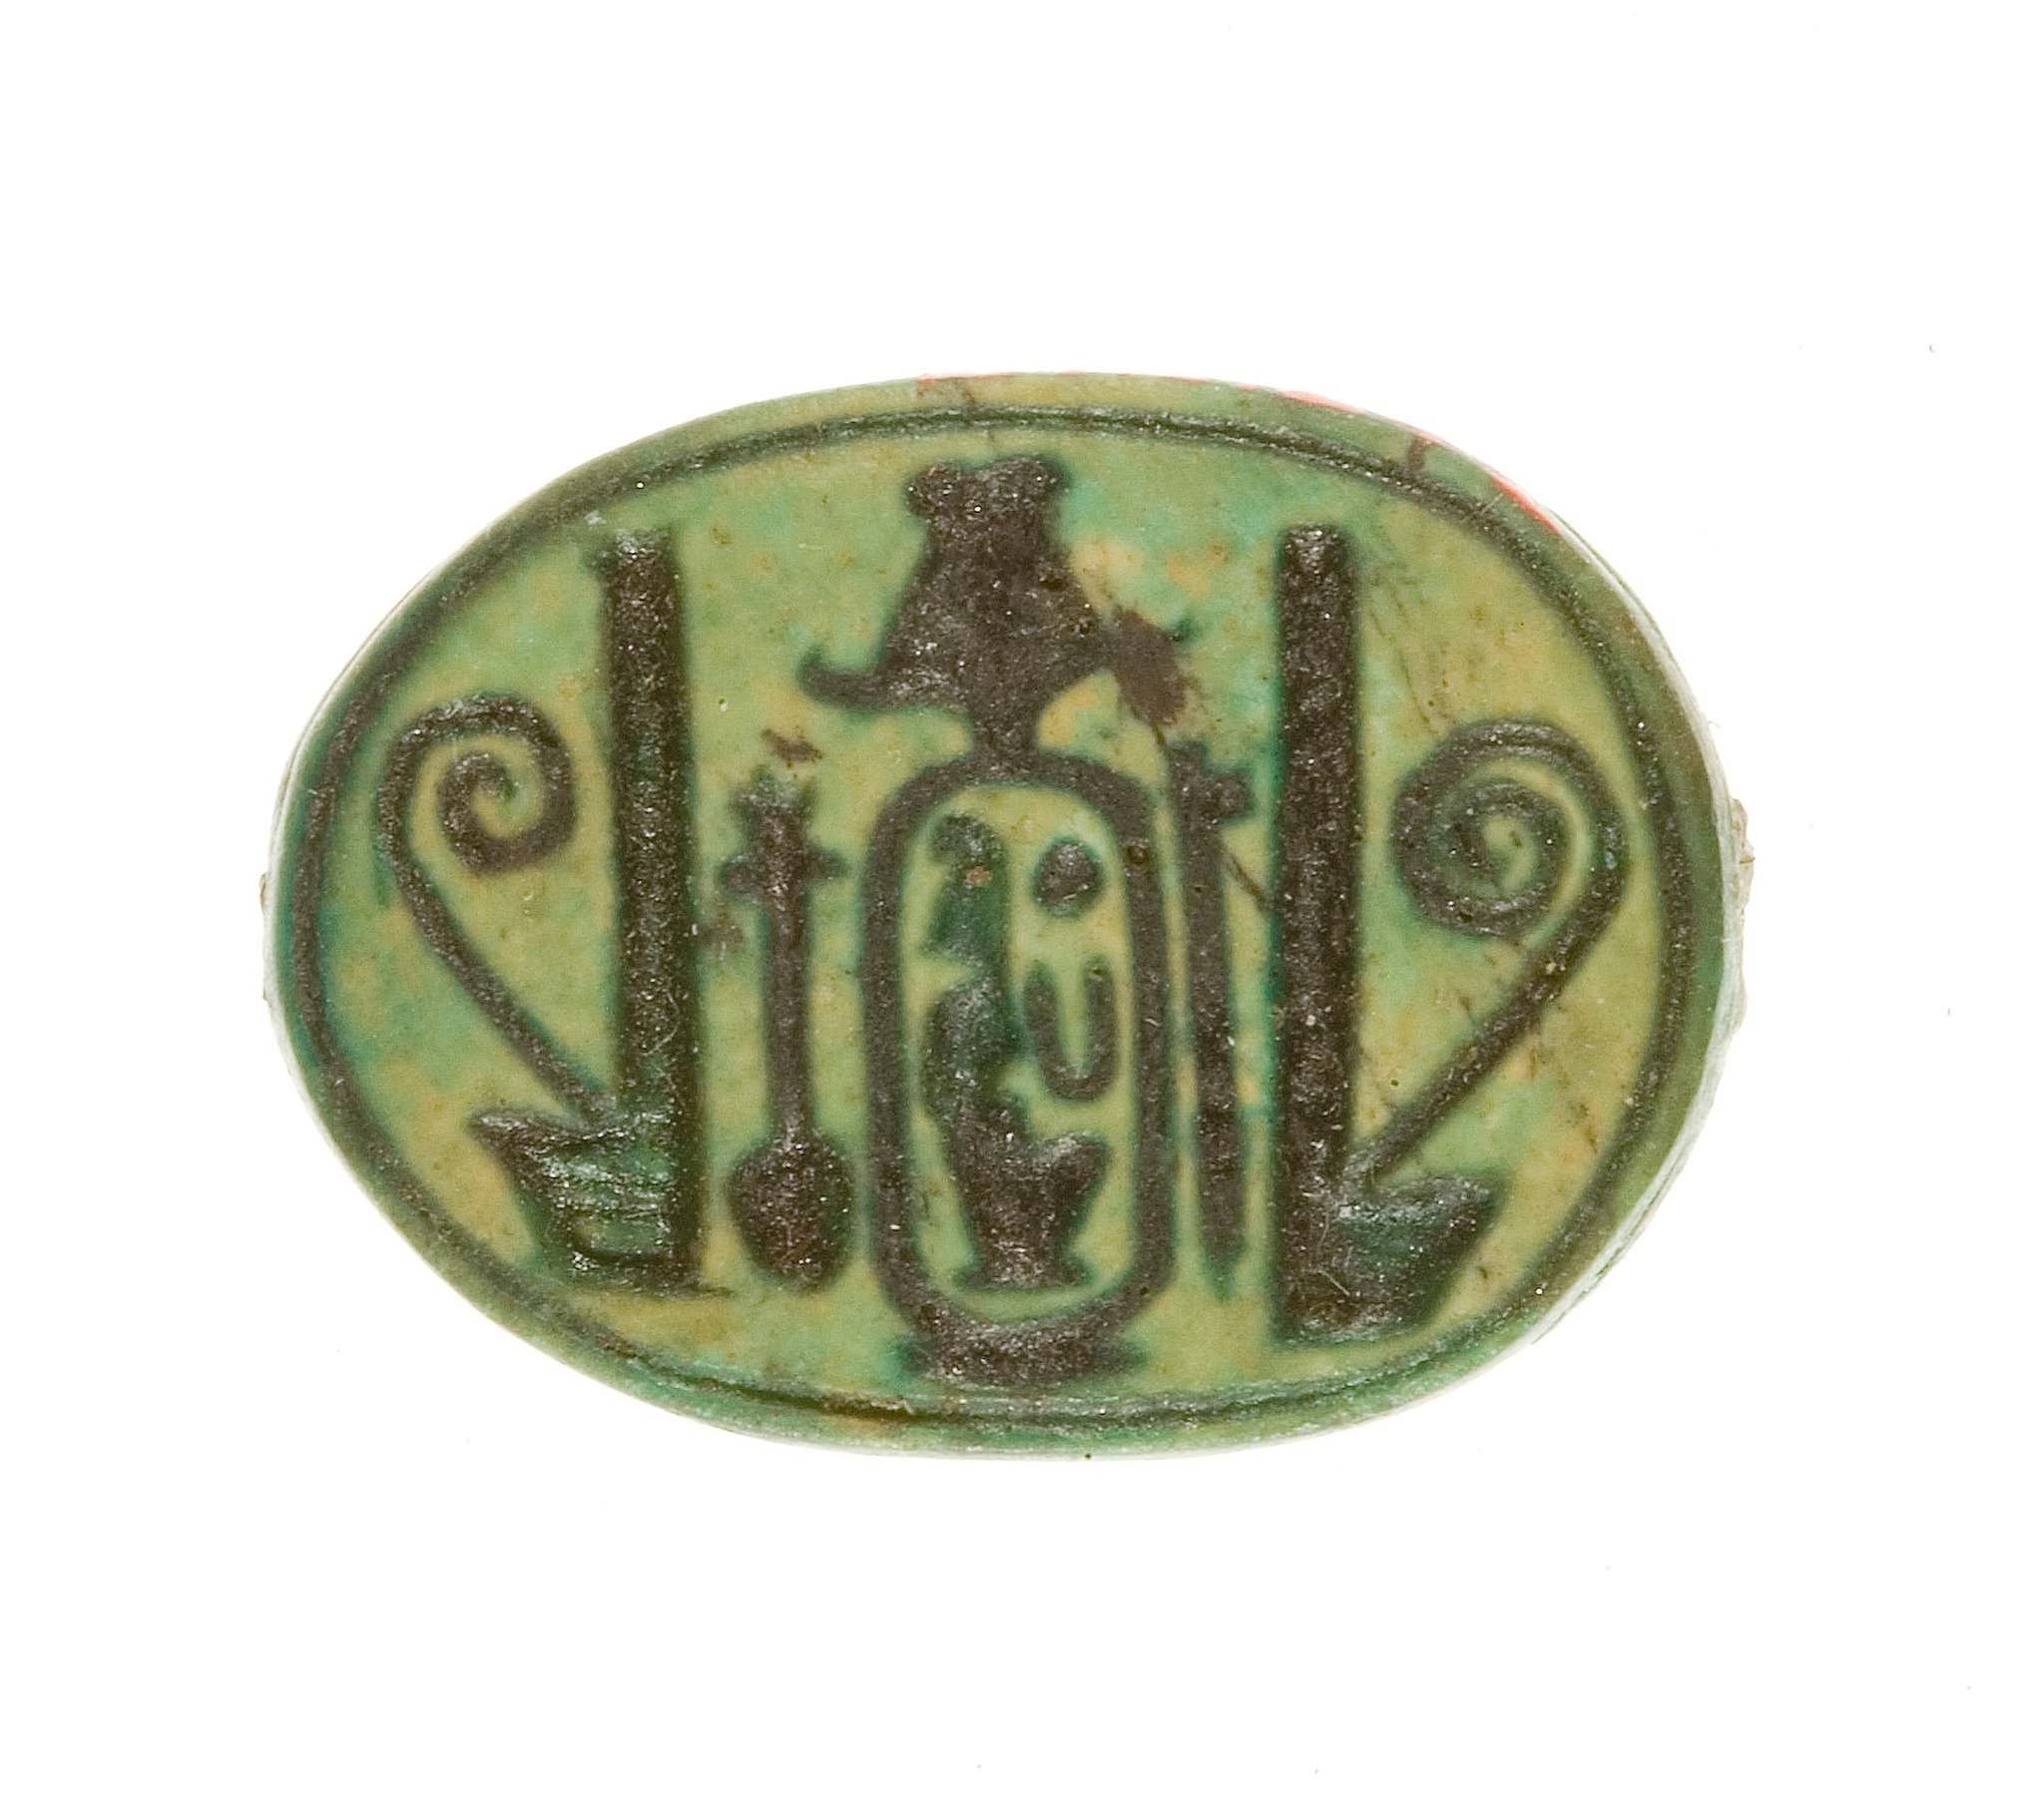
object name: scarab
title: Scarab Inscribed for the Perfect God Maatkare (Hatshepsut), Flanked by Two Red Crowns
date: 1479-1458 BCE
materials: stone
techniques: glazing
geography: egypt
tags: cartouches,hieroglyphs,scarabs